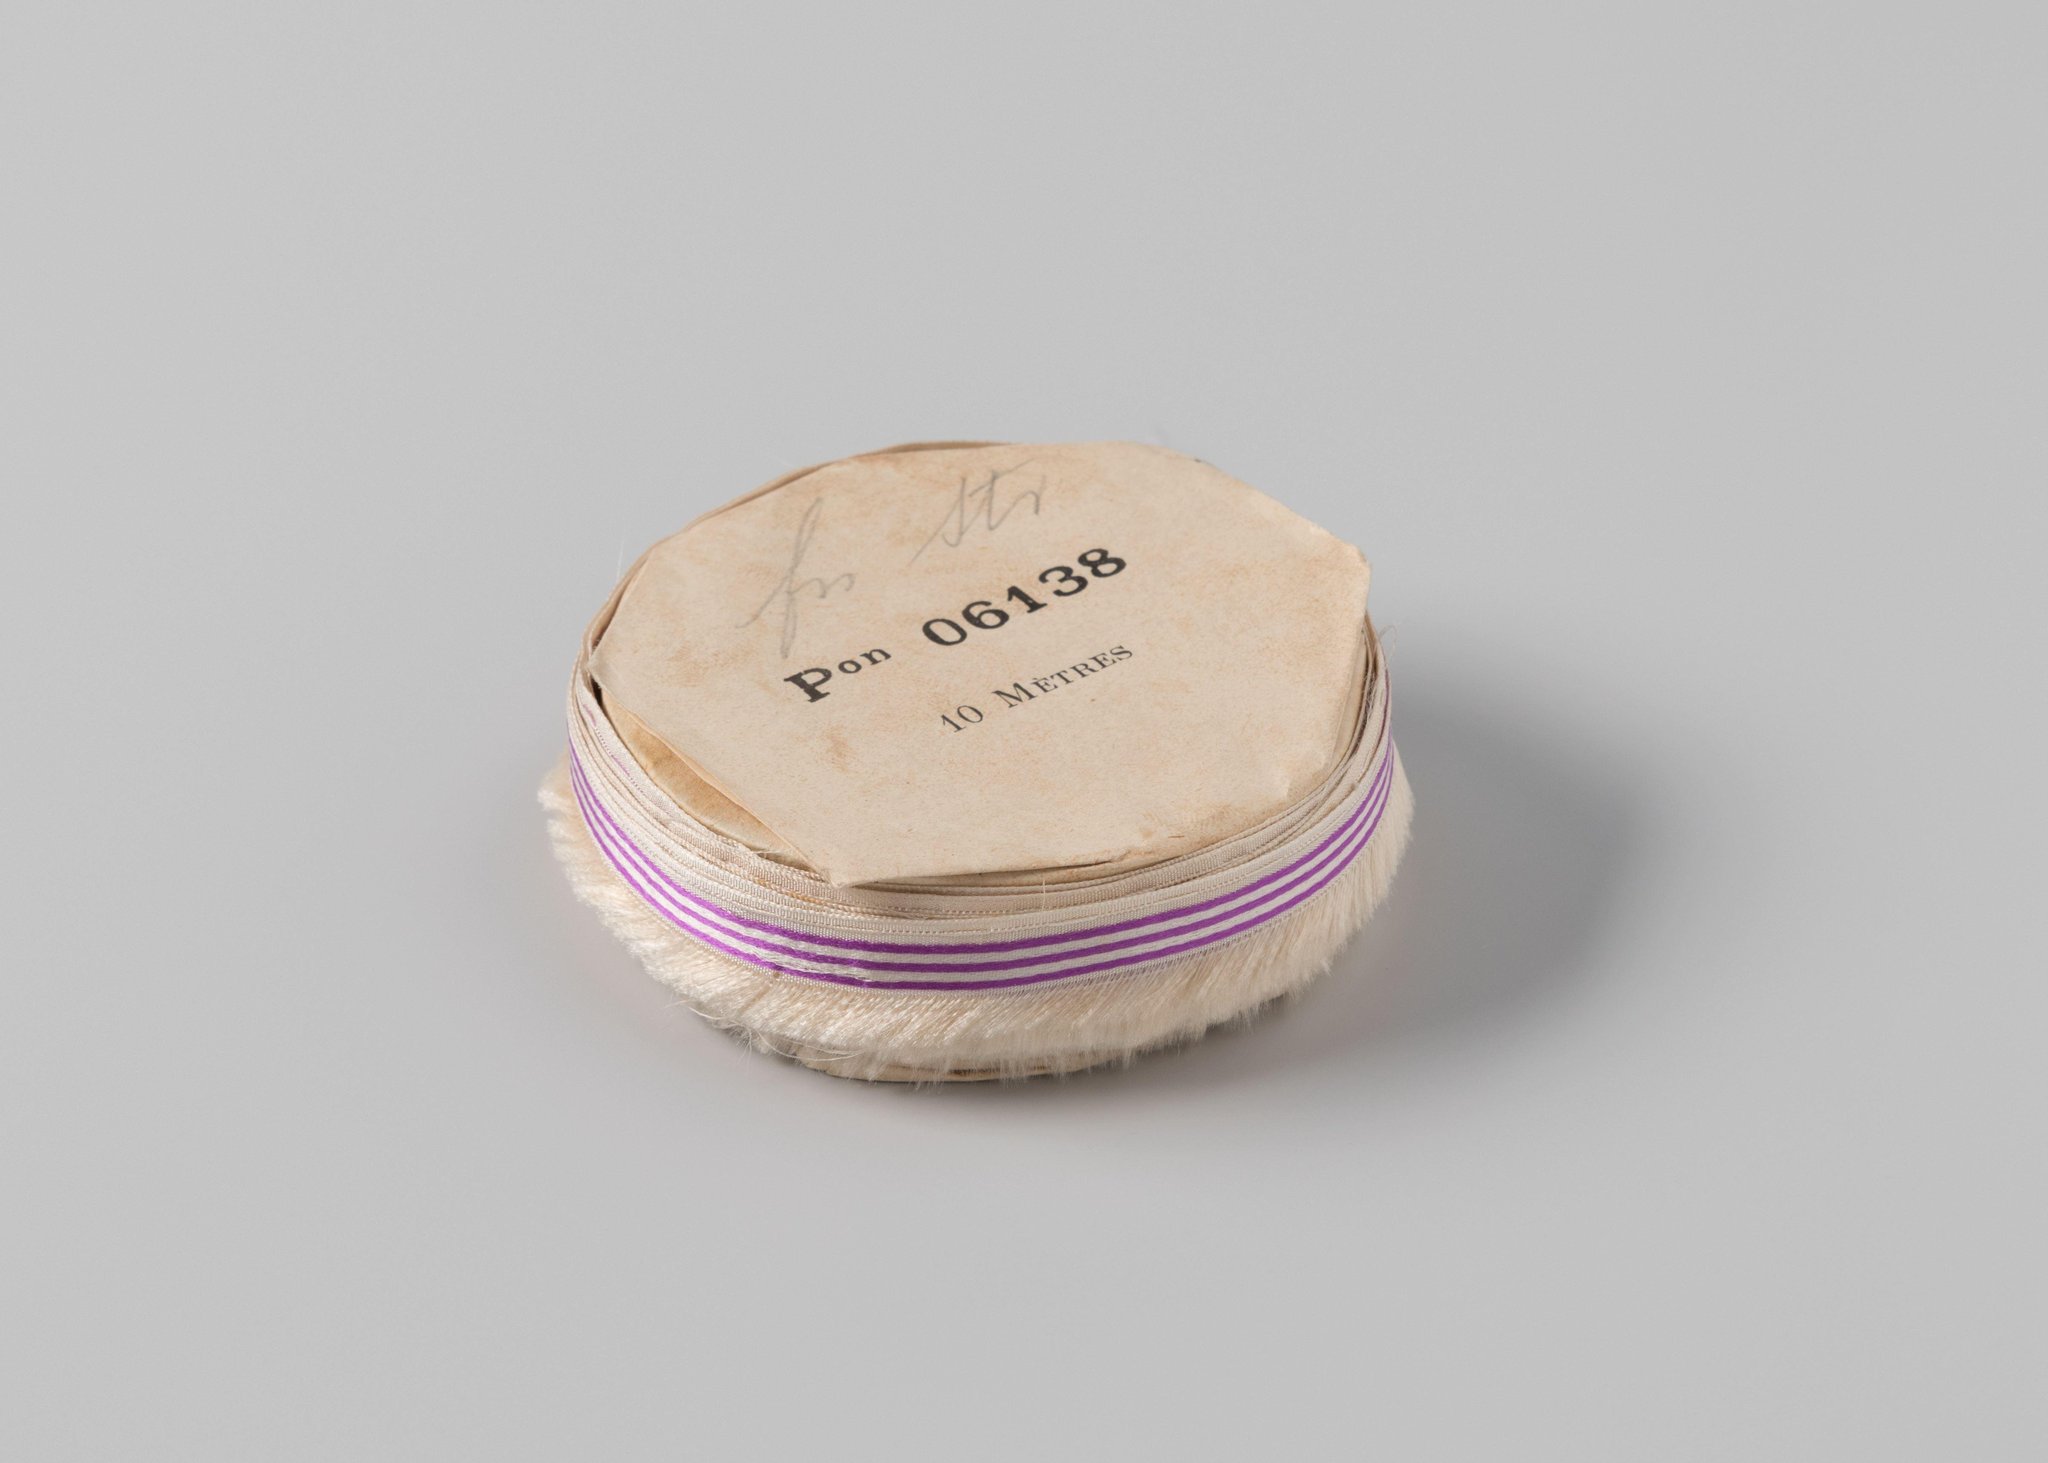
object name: ribbon material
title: Rol met wit lint met één gerafelde zijde en drie paarse horizontale strepen en een los stuk van hetzelfde lint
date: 1930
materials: cardboard, paper, textile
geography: nijmegen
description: Rol met wit lint met één gerafelde zijde en drie paarse horizontale strepen en een los stuk van hetzelfde lint